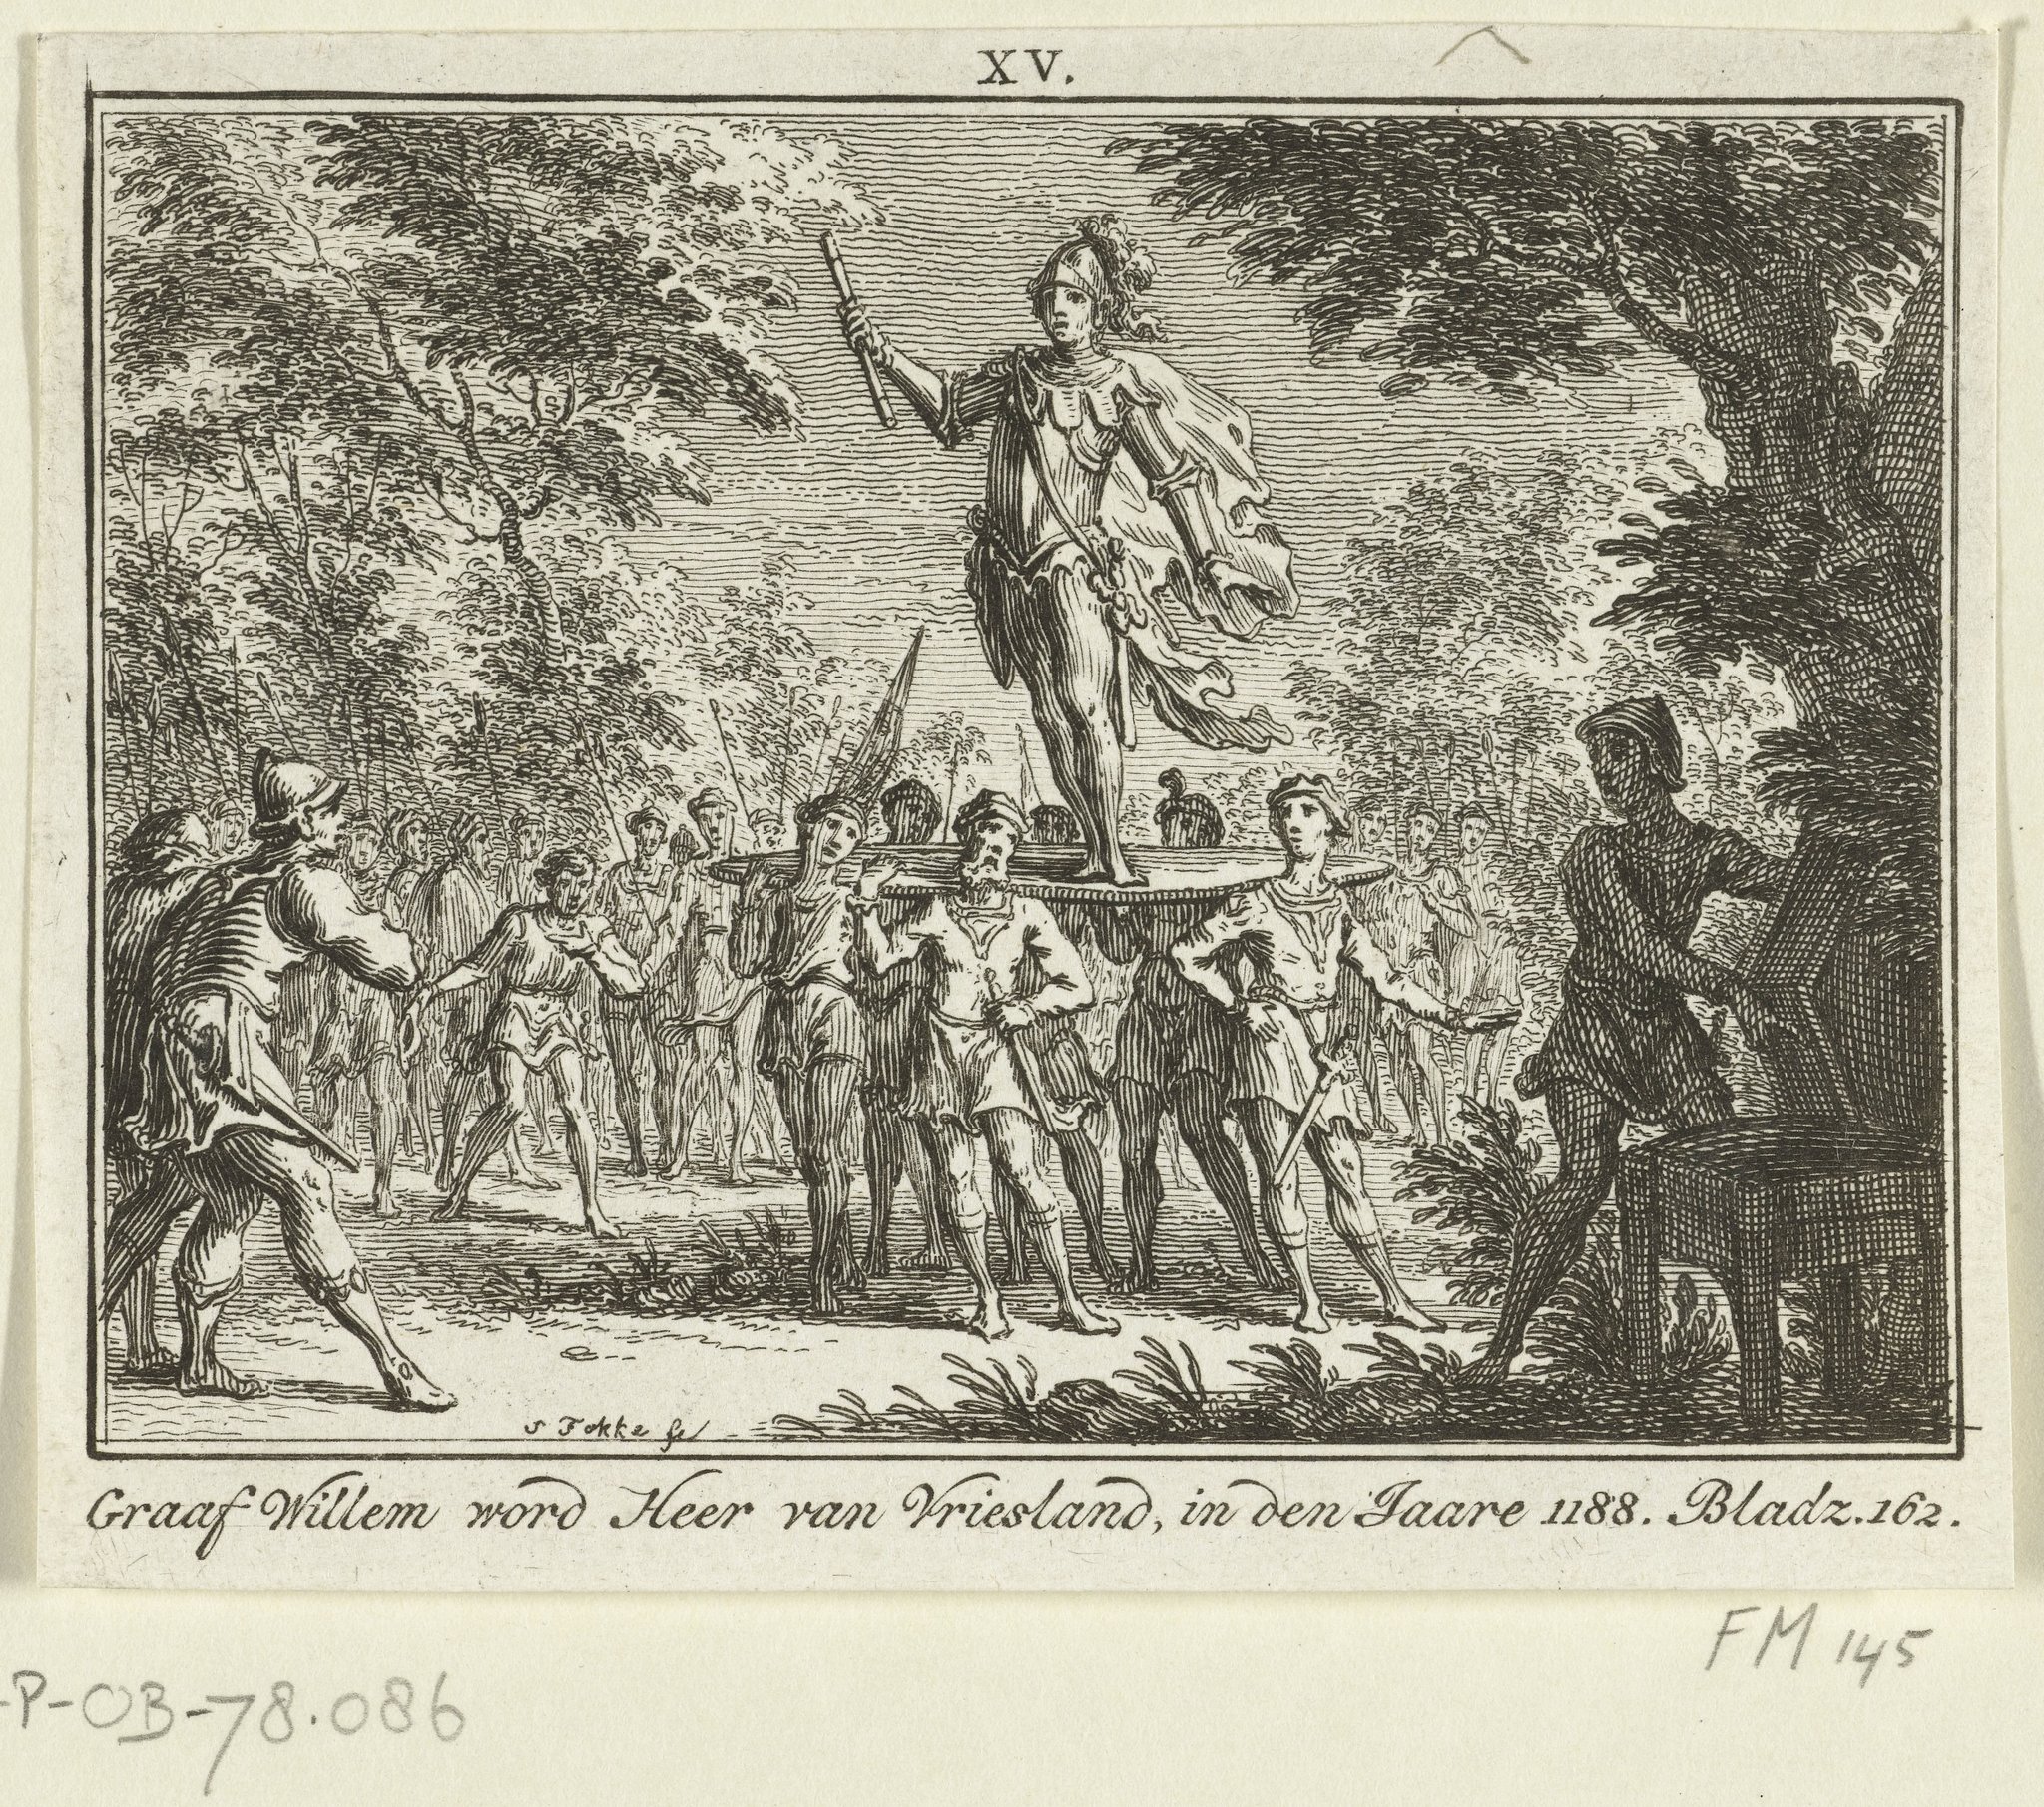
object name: history print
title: Willem I wordt Heer van Friesland, 1195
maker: simon fokke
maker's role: draughtsman, print maker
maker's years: 1712-1784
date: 1722-1750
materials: paper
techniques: etching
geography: northern netherlands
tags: netherlands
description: Illustratie voor een onbekend werk, later hergebruikt in: J.W. te Water, De vaderlandsche Historie van den heere J. Wagenaar, verkort, en met leerzaame aanmerkingen, ten dienste der Nederlandsche jeugd, 1784-1800, 4 delen, pl. XV, blz. 162.